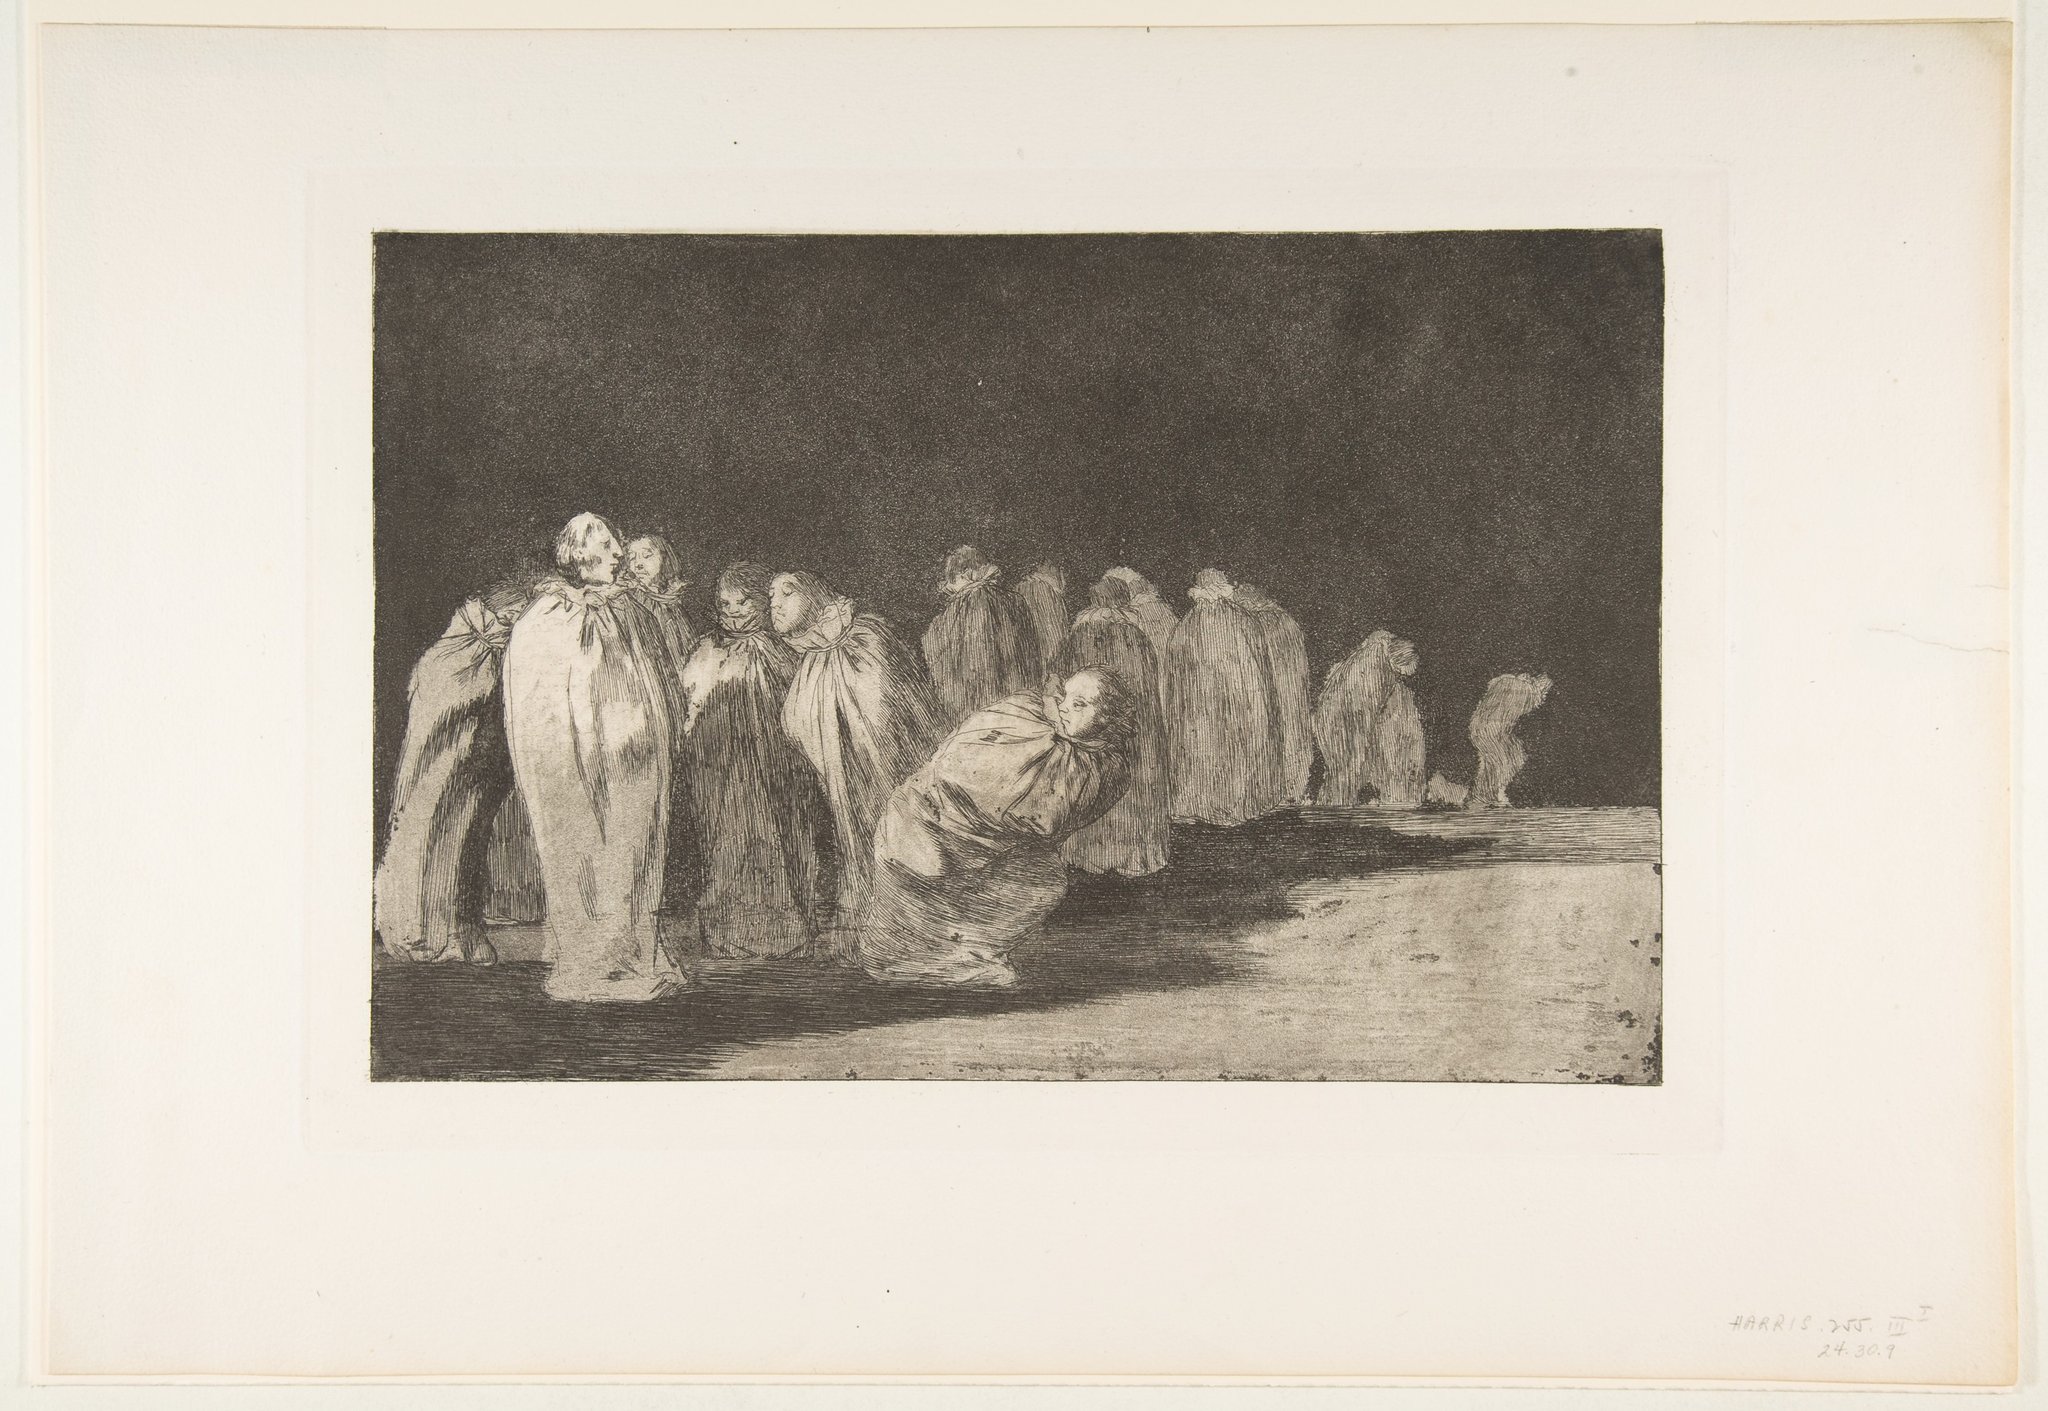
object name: print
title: Men in Sacks, from "The Disparates" (Follies / Irrationalities)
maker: goya (francisco de goya y lucientes)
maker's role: artist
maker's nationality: spanish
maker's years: 1746-1828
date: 1815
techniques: aquatint, burnishing, etching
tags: men